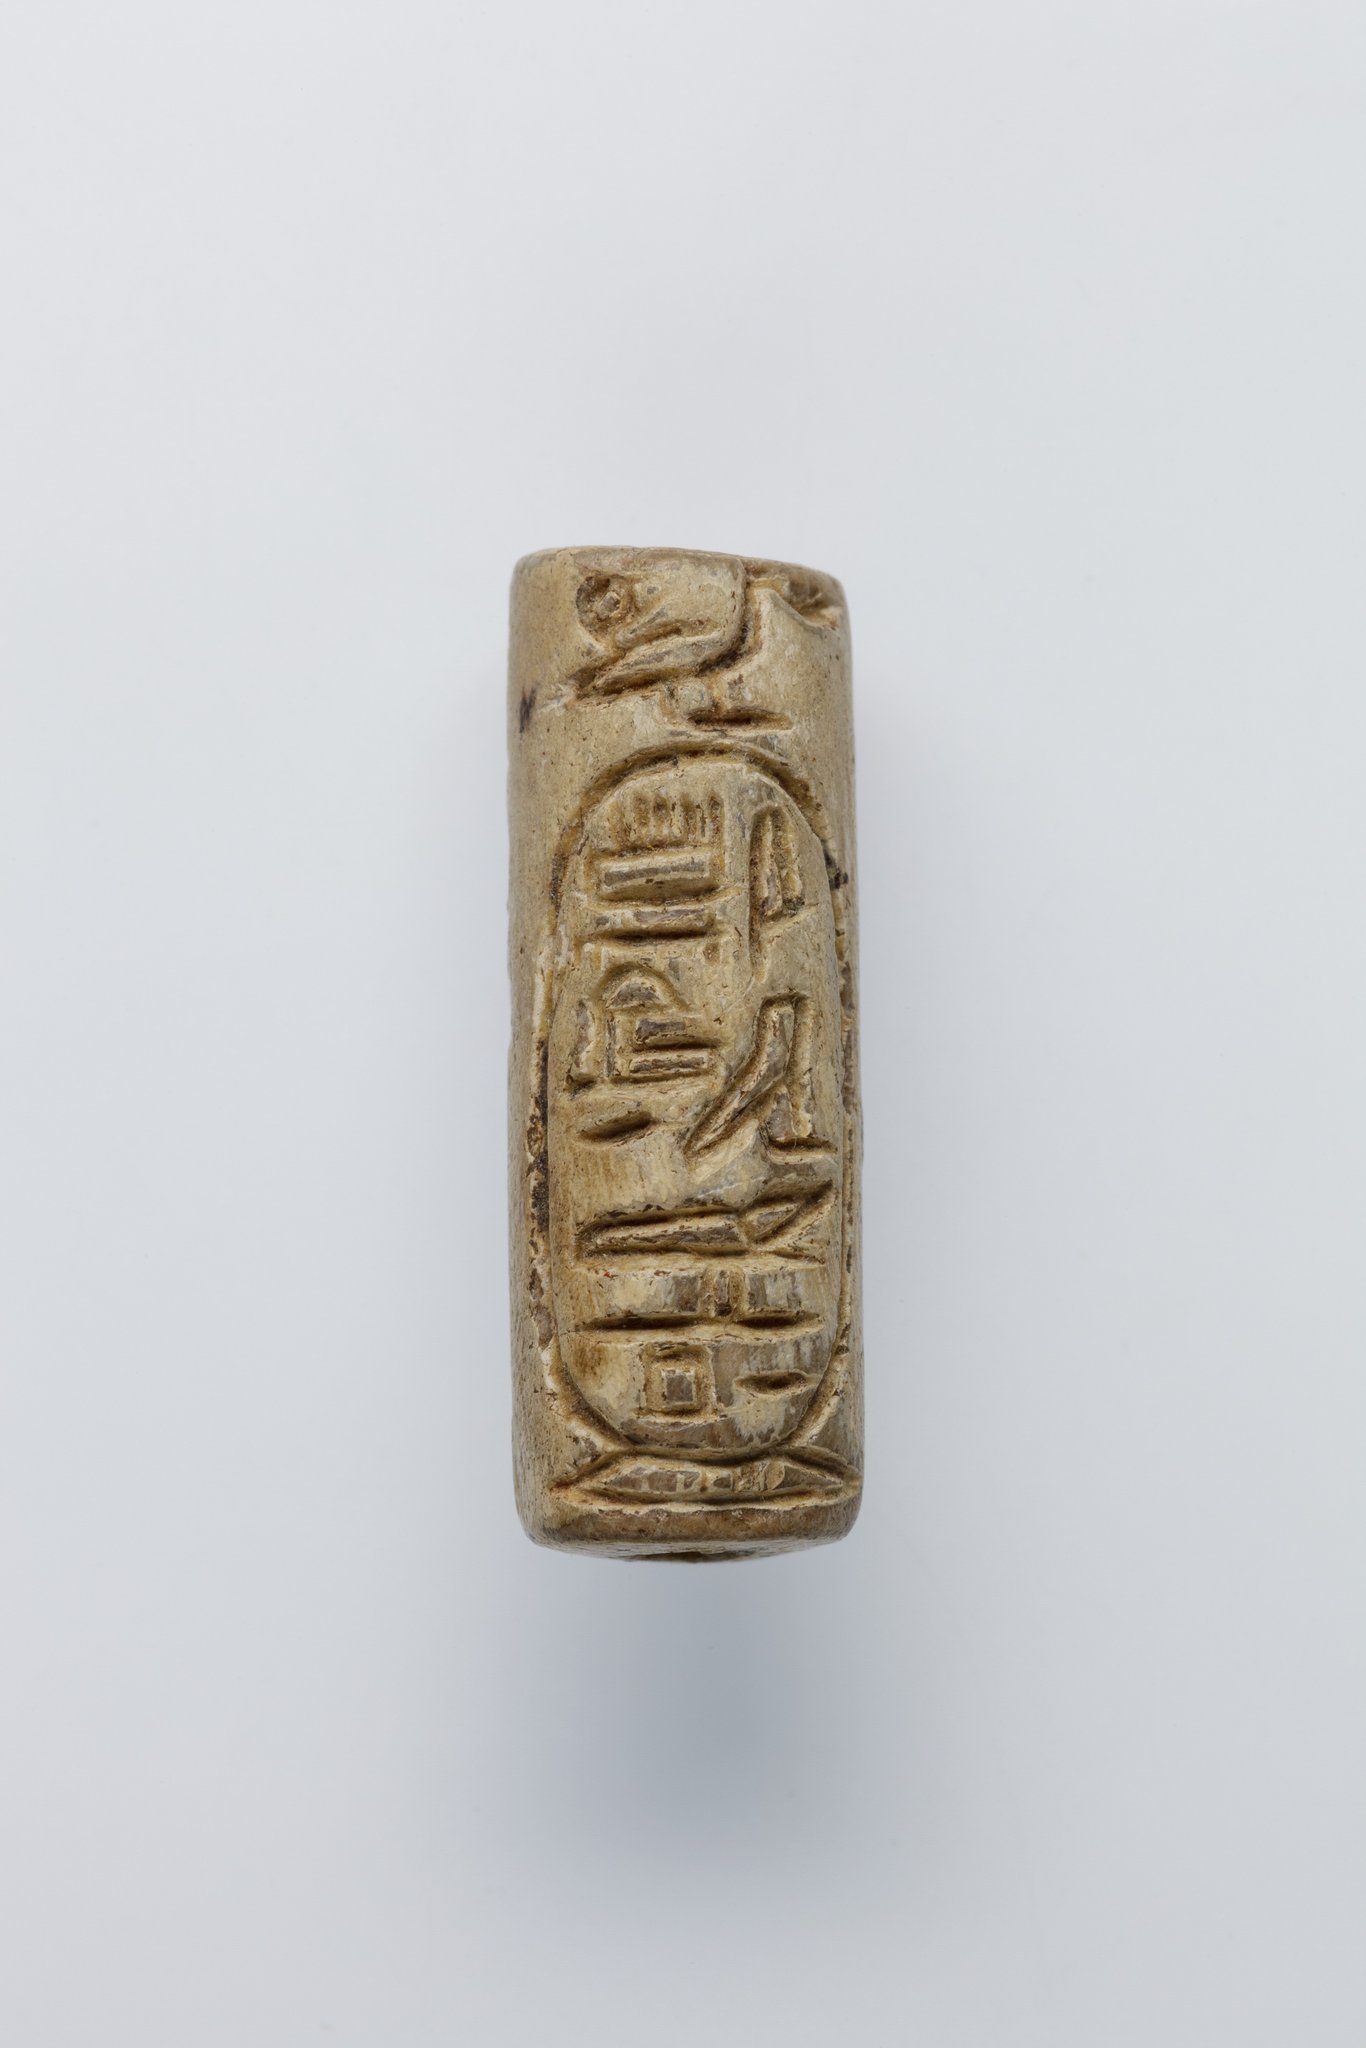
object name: cylinder seal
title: Cylinder Seal of King Amenemhat Sebekhotep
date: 1765-1763 BCE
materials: stone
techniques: glazing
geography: egypt